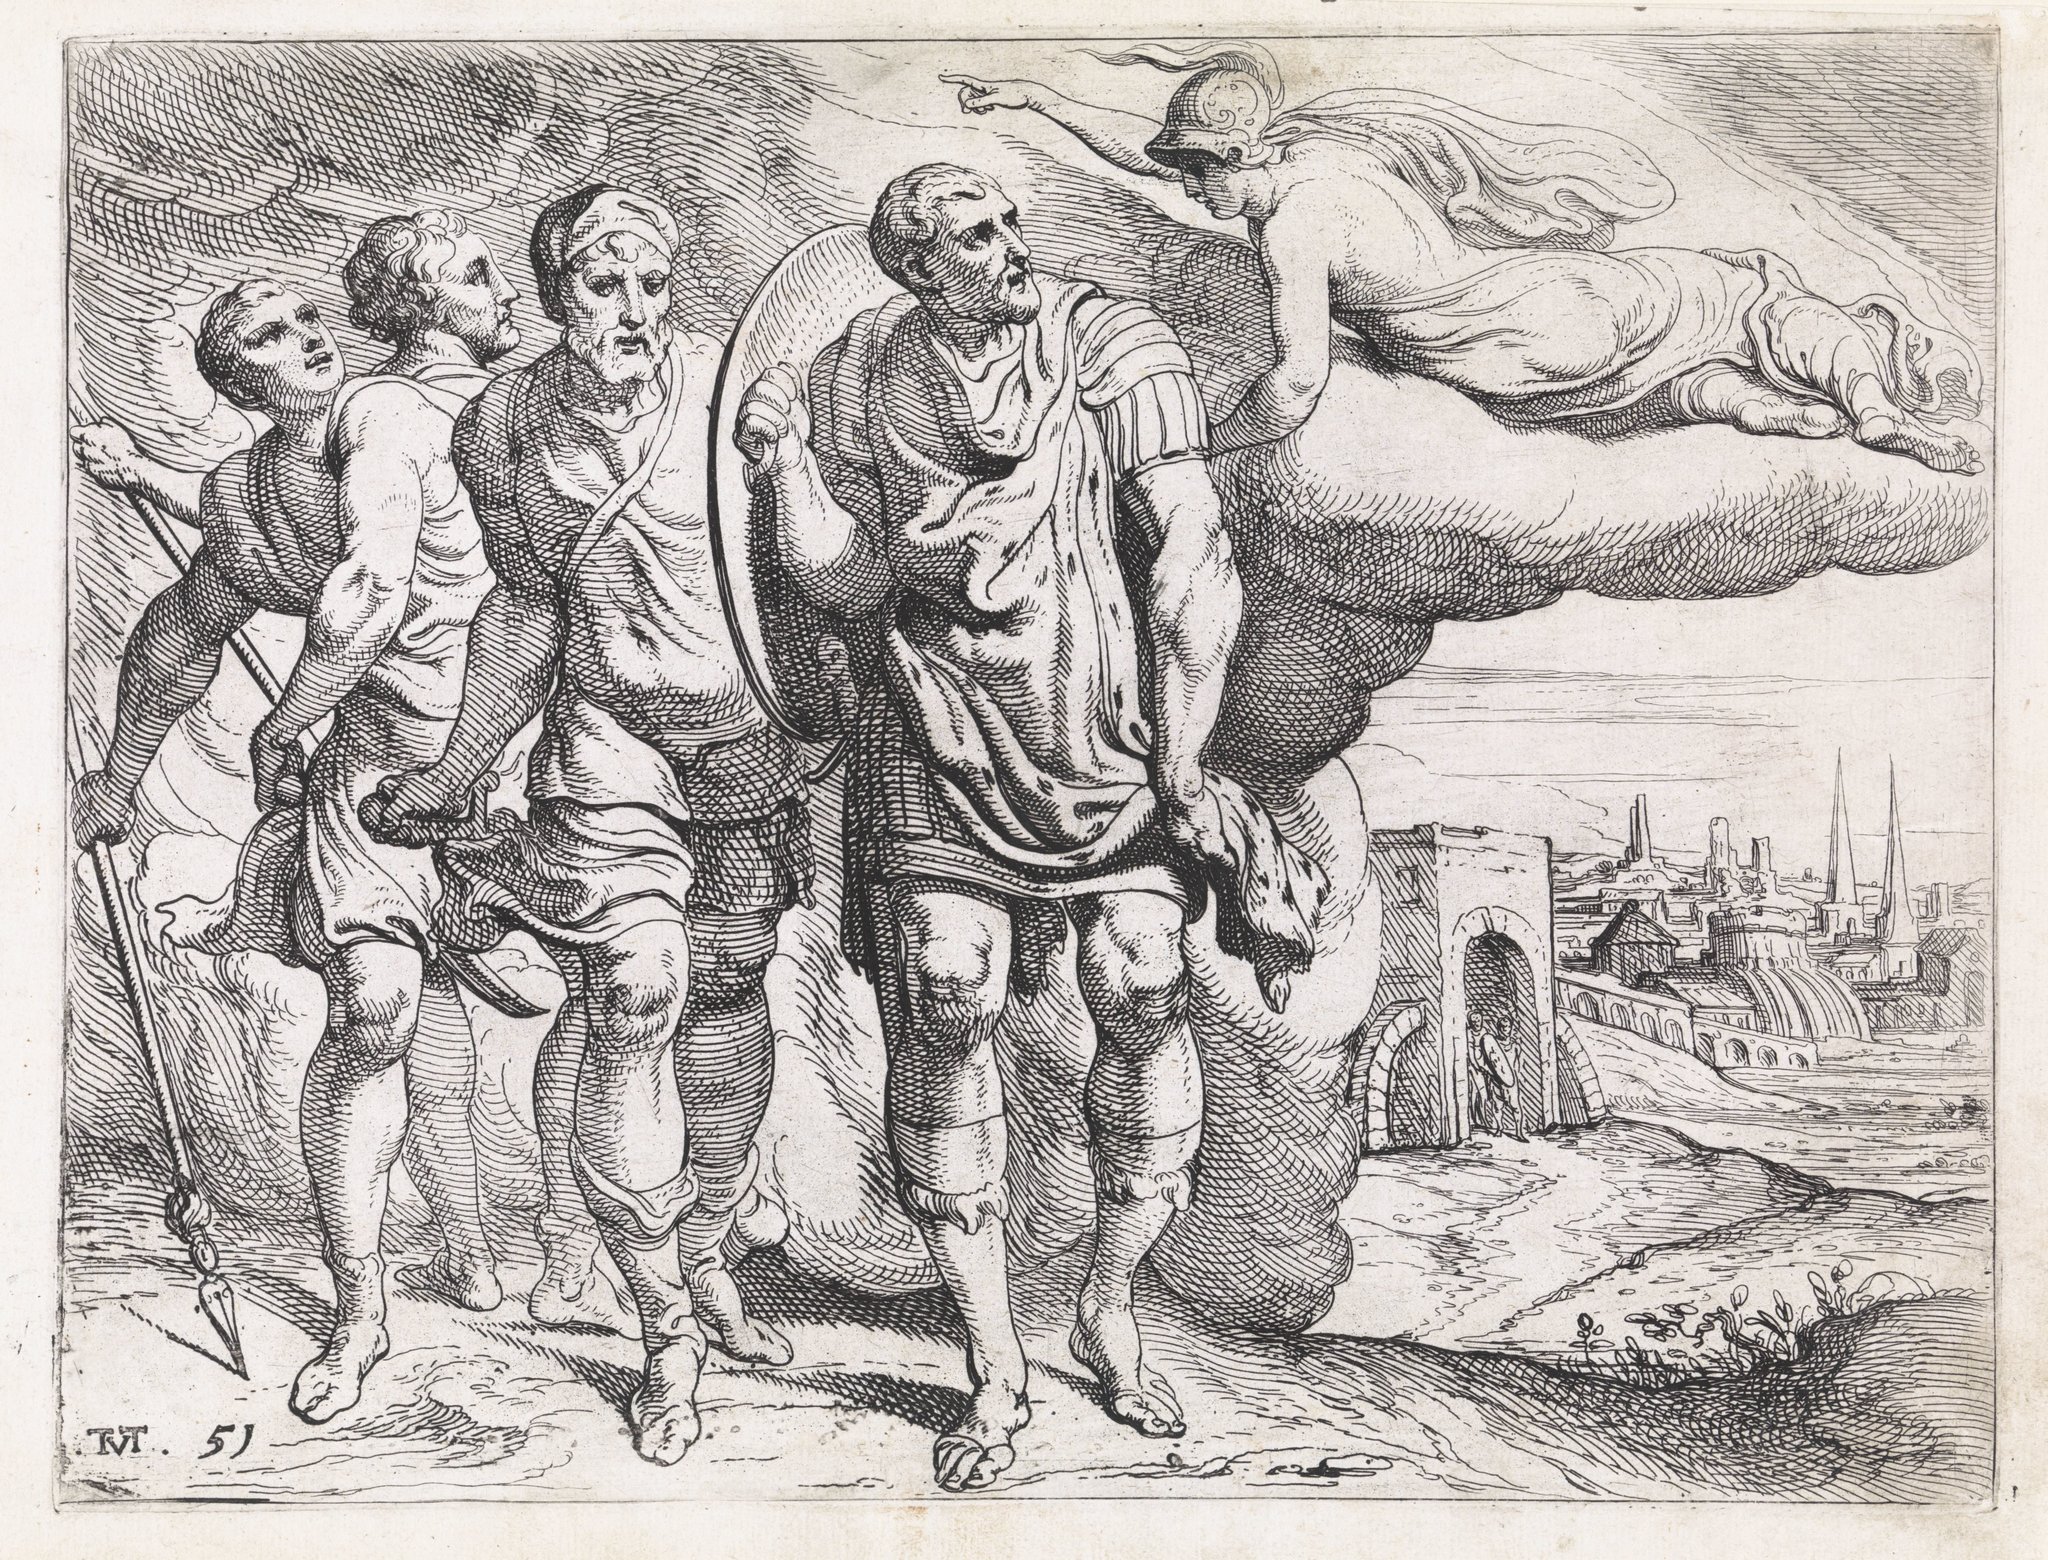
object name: print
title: De werken van Odysseus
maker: theodoor van thulden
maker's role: draughtsman, painter, print maker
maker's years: 1606-1669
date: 1632-1633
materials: paper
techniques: engraving, etching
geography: paris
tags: sequel to the death of the suitors (homer, odyssey xxiv), (story of) minerva (pallas, athena)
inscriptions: collector's mark: Lugt 2228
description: Odysseus, zijn zoon Telemachus, Eumaeus en Philoetius verlaten gewapend het paleis en gaan onderweg naar de vader van Odysseus: Laërtes. Minerva verbergt hen in duisternis op klaarlichte dag, zodat ze ongezien wegkomen.